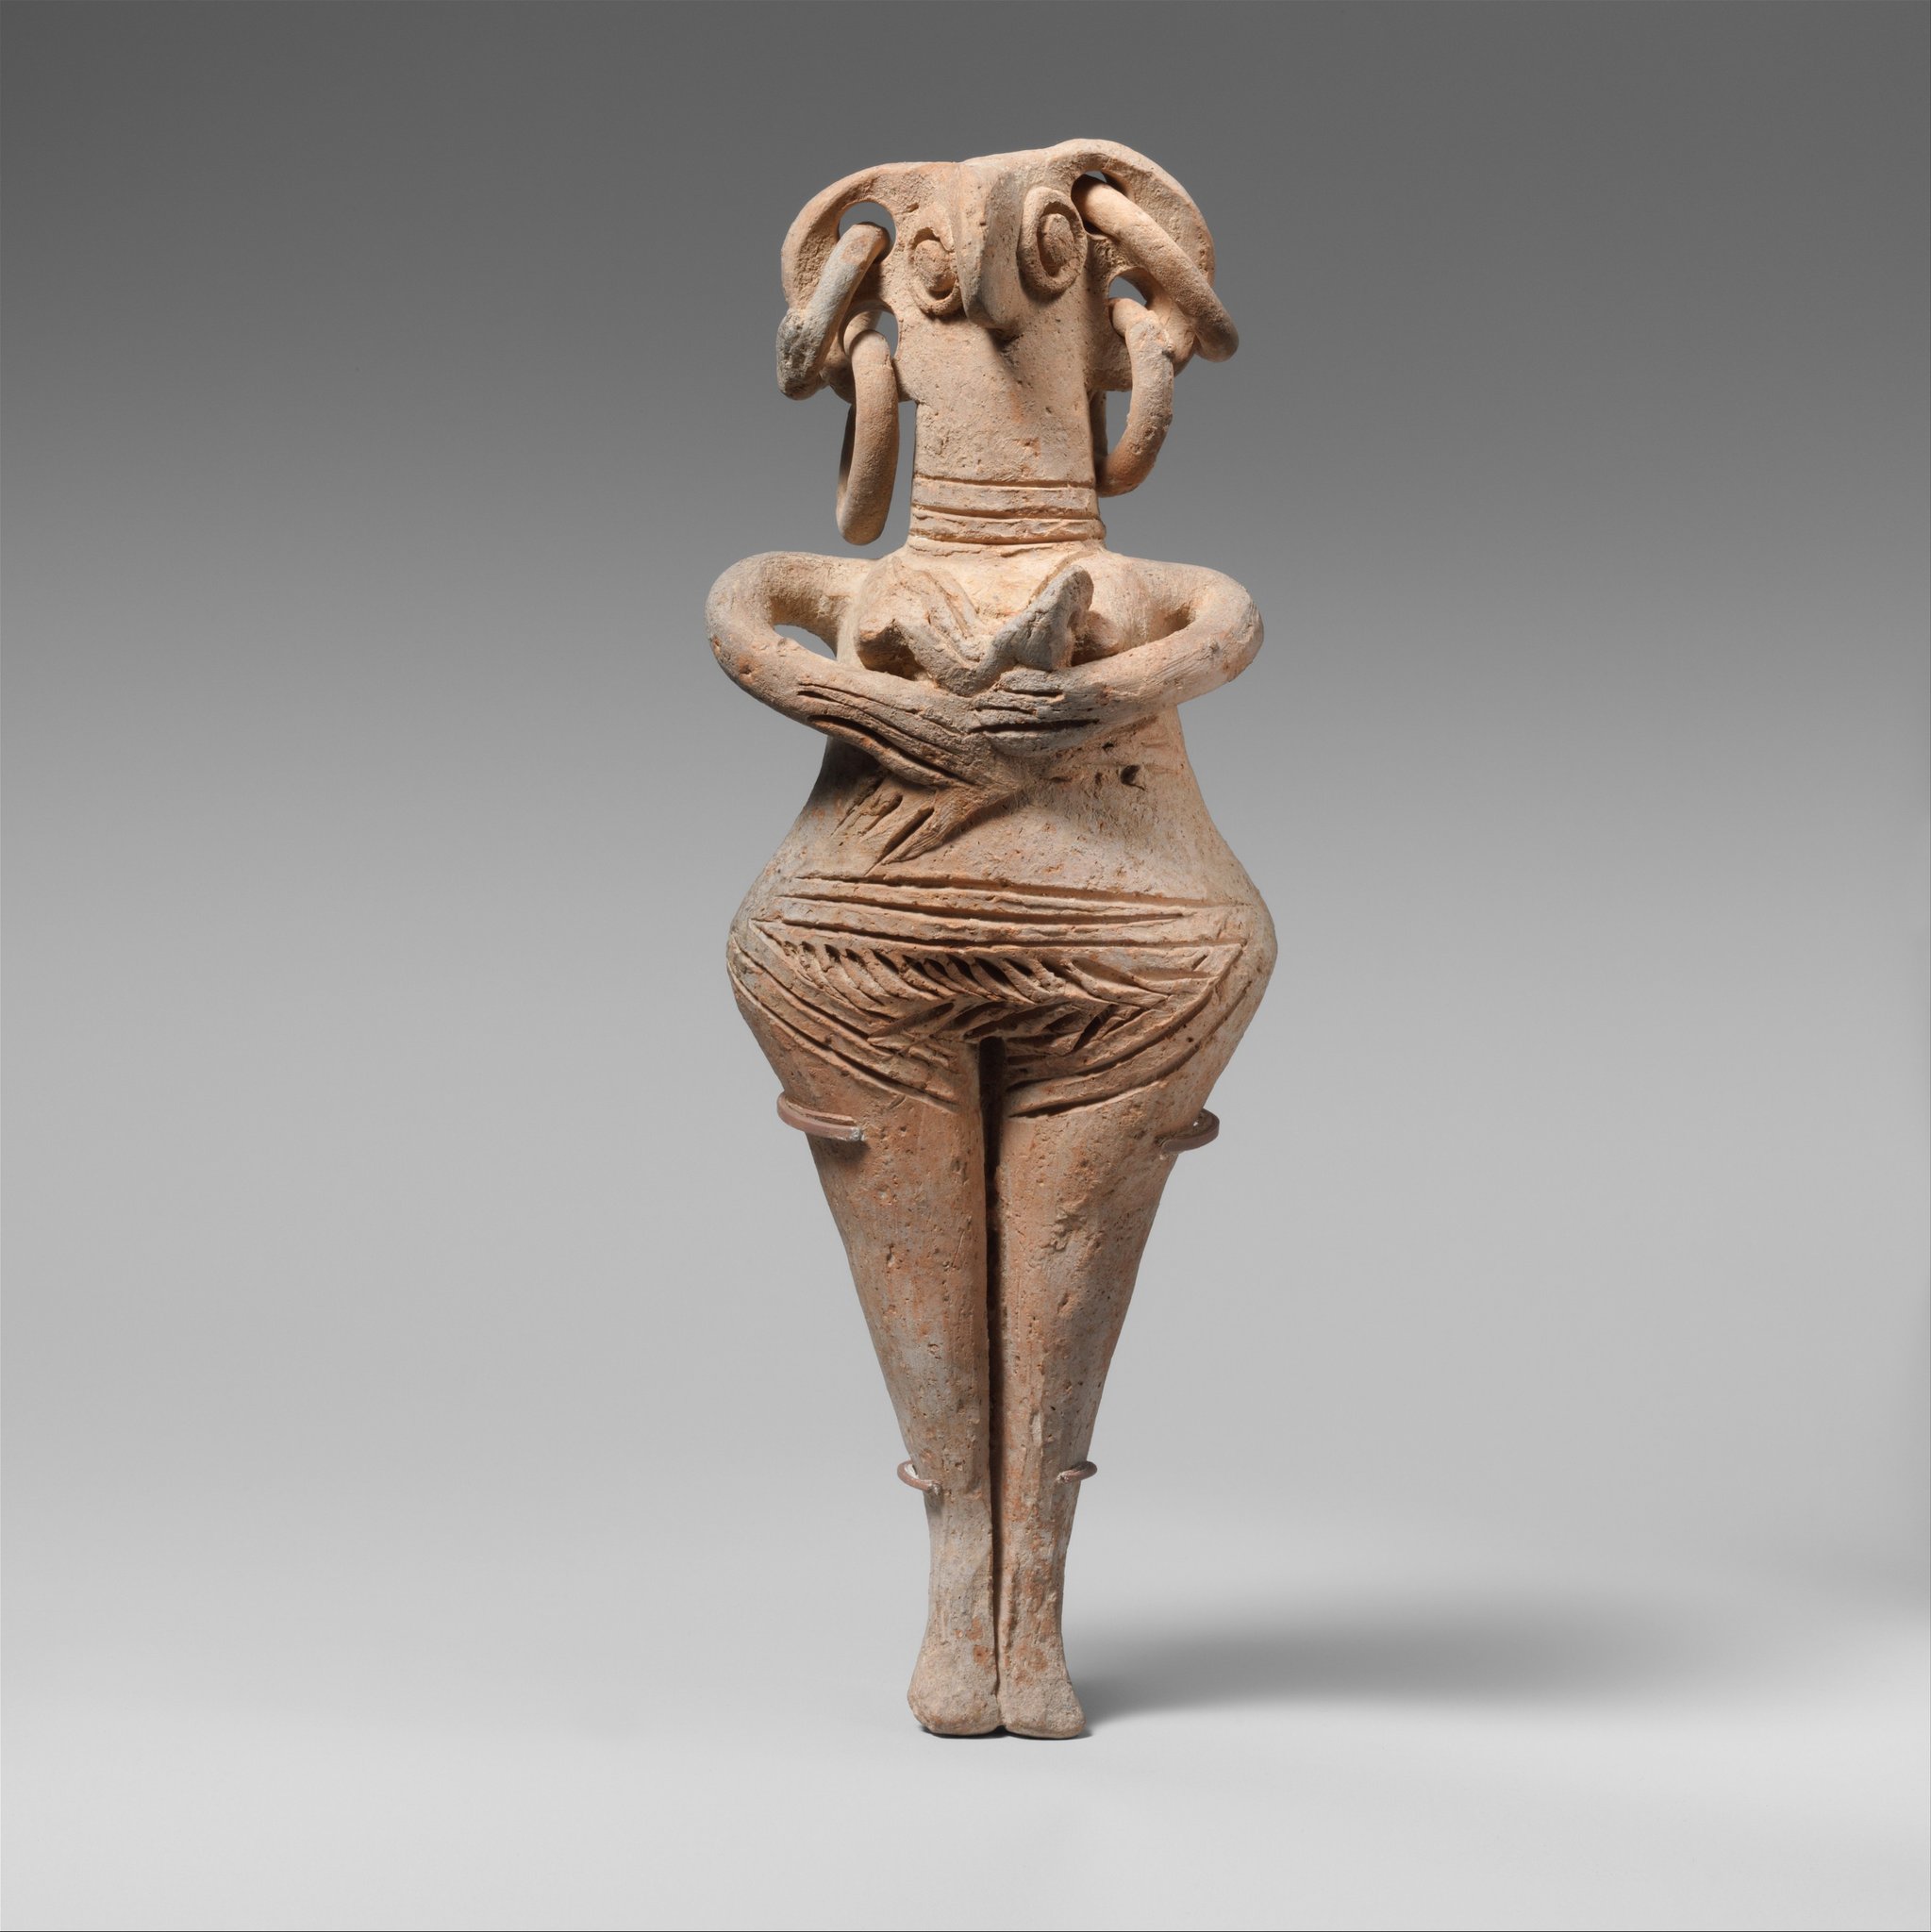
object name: statuette of a woman with bird face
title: Terracotta statuette of woman with bird face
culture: cypriot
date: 1450-1200 BCE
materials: terracotta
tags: birds,women